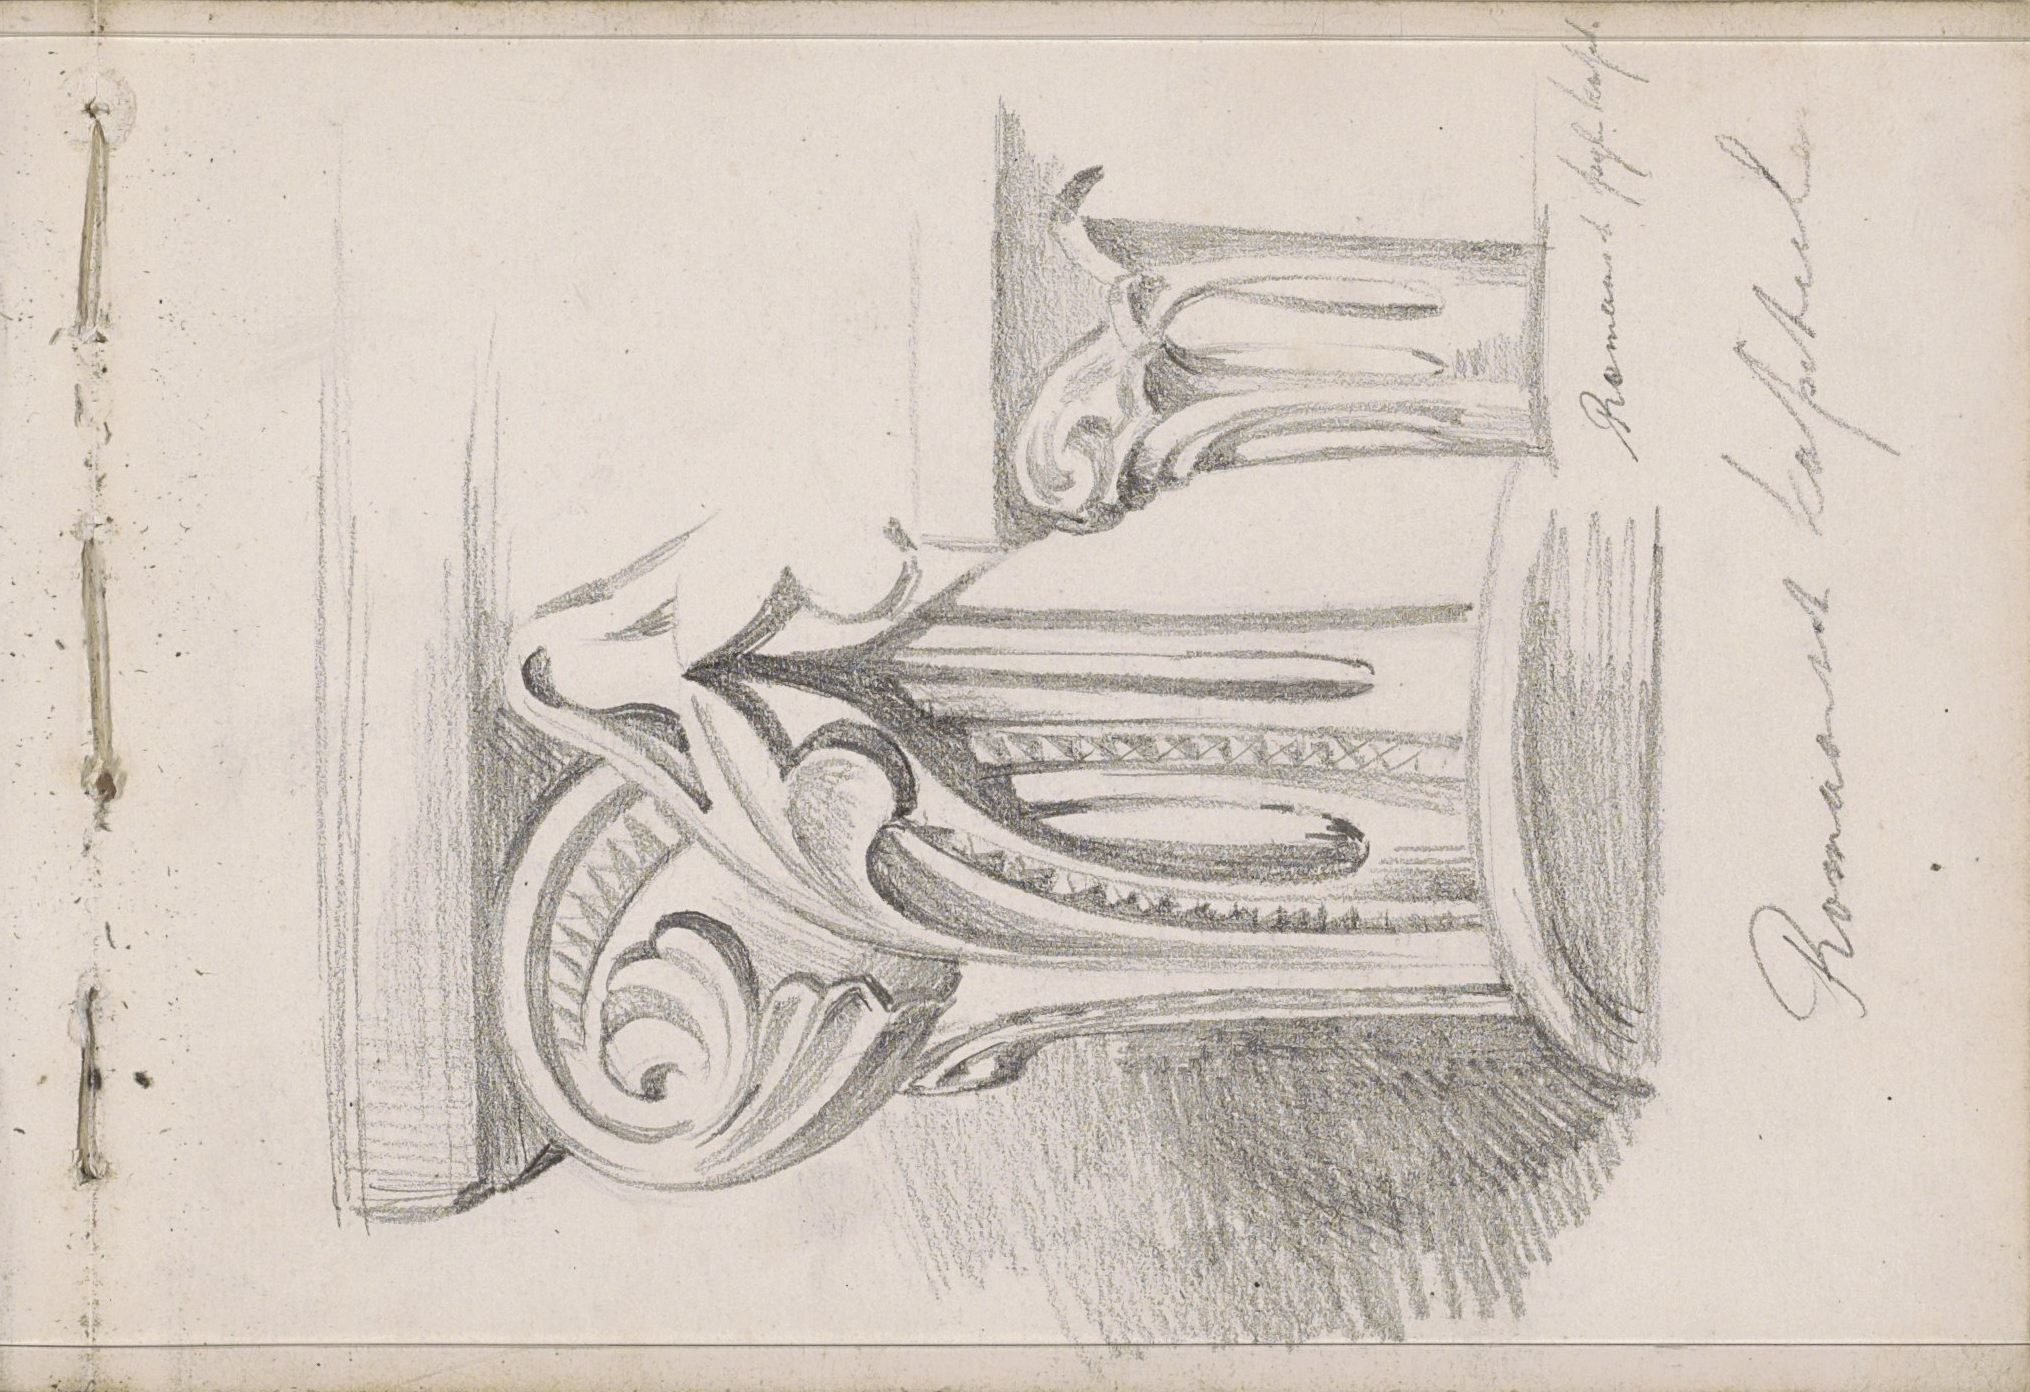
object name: sketchbook leaf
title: Romaanse kapitelen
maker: jac van looij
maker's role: draughtsman, painter, print maker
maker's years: 1855-1930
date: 1877-1880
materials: paper, pencil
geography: amsterdam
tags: capital (~ column, pillar)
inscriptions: annotation: ‘Romaansch pyl kap[...]/ Romaansch kapiteelen’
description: Blad 2 recto uit een schetsboek met 27 bladen.